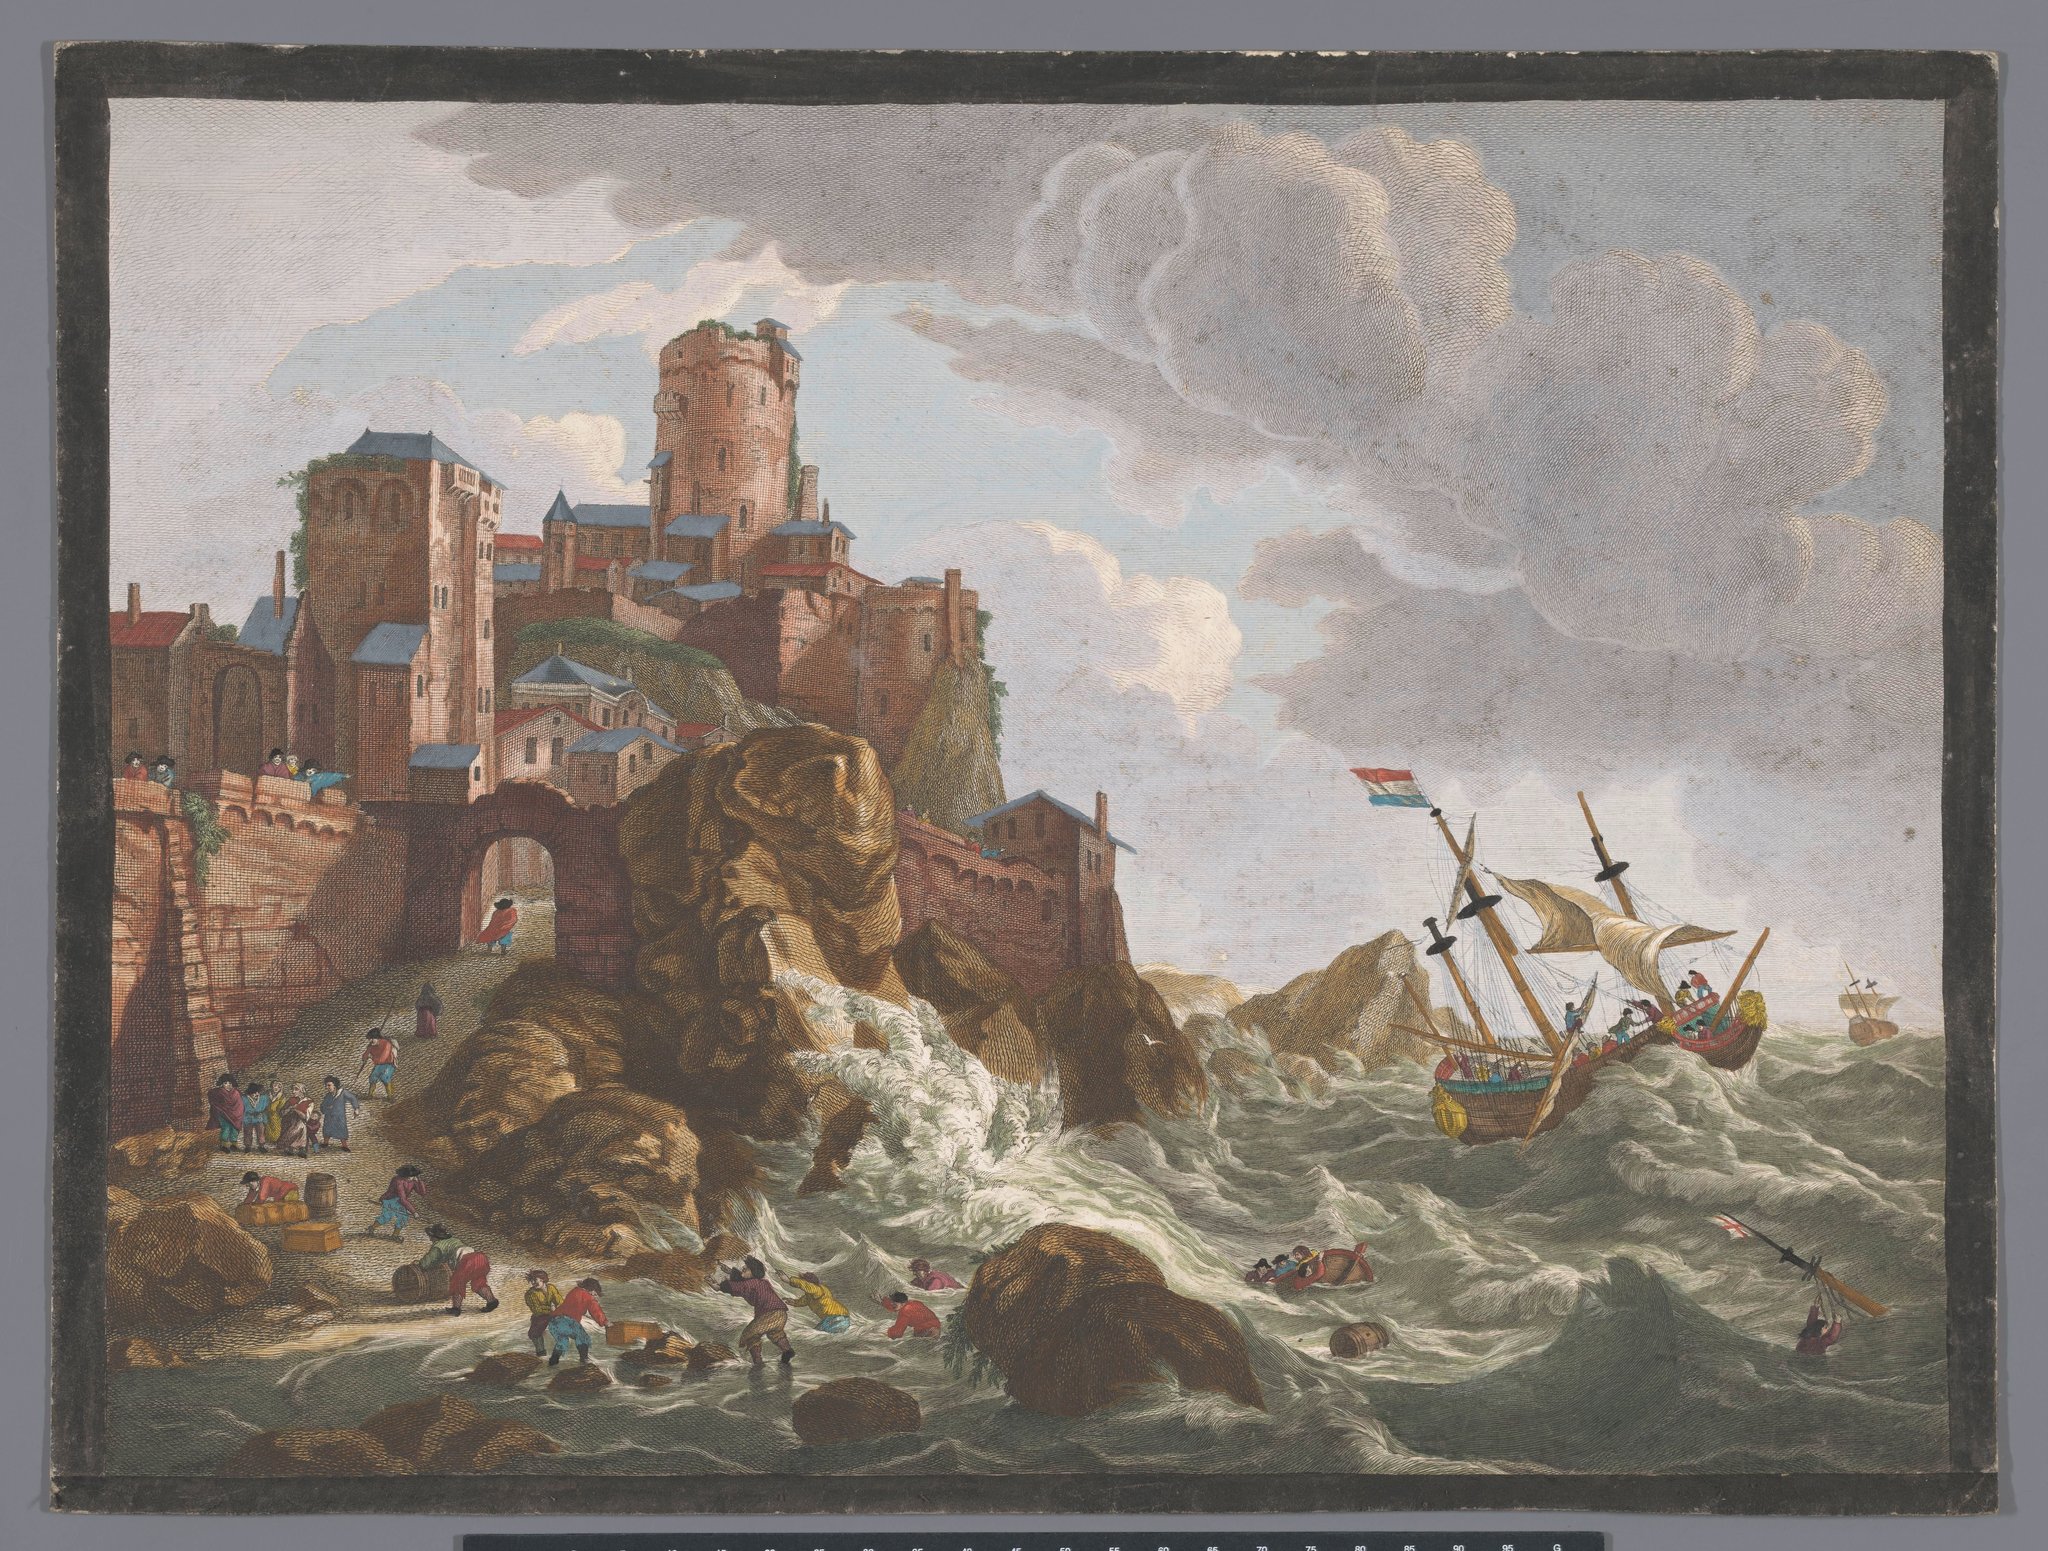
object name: print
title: Gezicht op een kust met schepen en boten op de klippen te Noorwegen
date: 1700-1799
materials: cardboard, paper, watercolor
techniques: brush, etching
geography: paris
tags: shipping accident; sickness and death at sea, sailing-ship, sailing-boat, rocky coast, rowing-boat, canoe, etc., sea (seascape) (+ landscape with figures, staffage), civic architecture; edifices; dwellings, norway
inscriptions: collector's mark: Lugt 2233